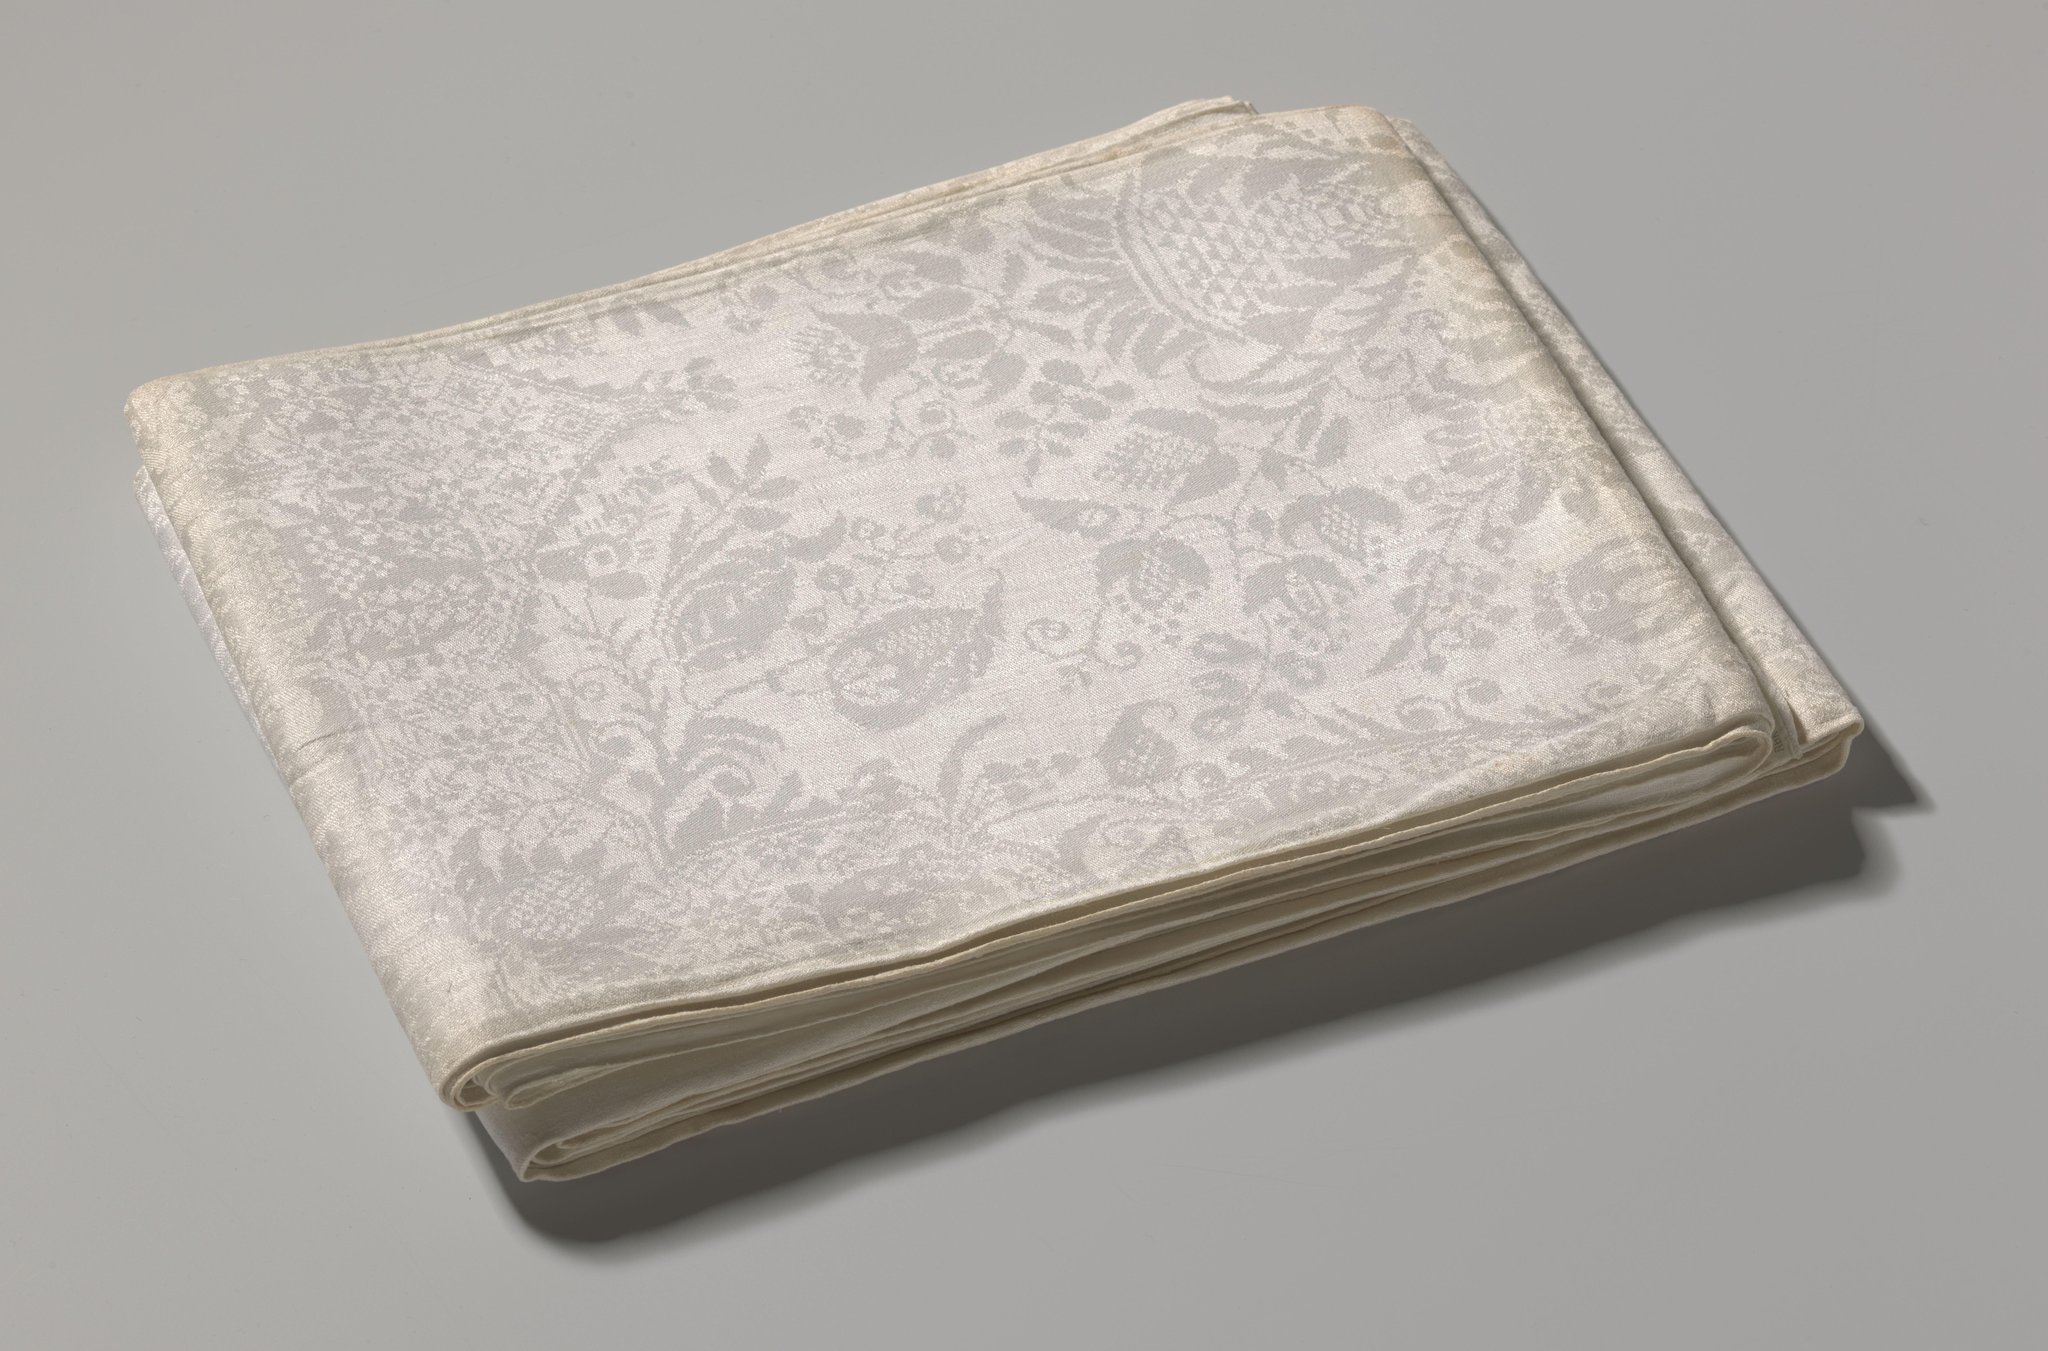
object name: tablecloth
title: Tafellaken van linnendamast met een bloemen- en kantpatroon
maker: Anonymous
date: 1725-1730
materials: linen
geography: flanders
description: Wit linnendamasten tafellaken, vlak volledig gevuld met verschillende bloemen, ananas, granaatappels met een slingered kantpatroon.